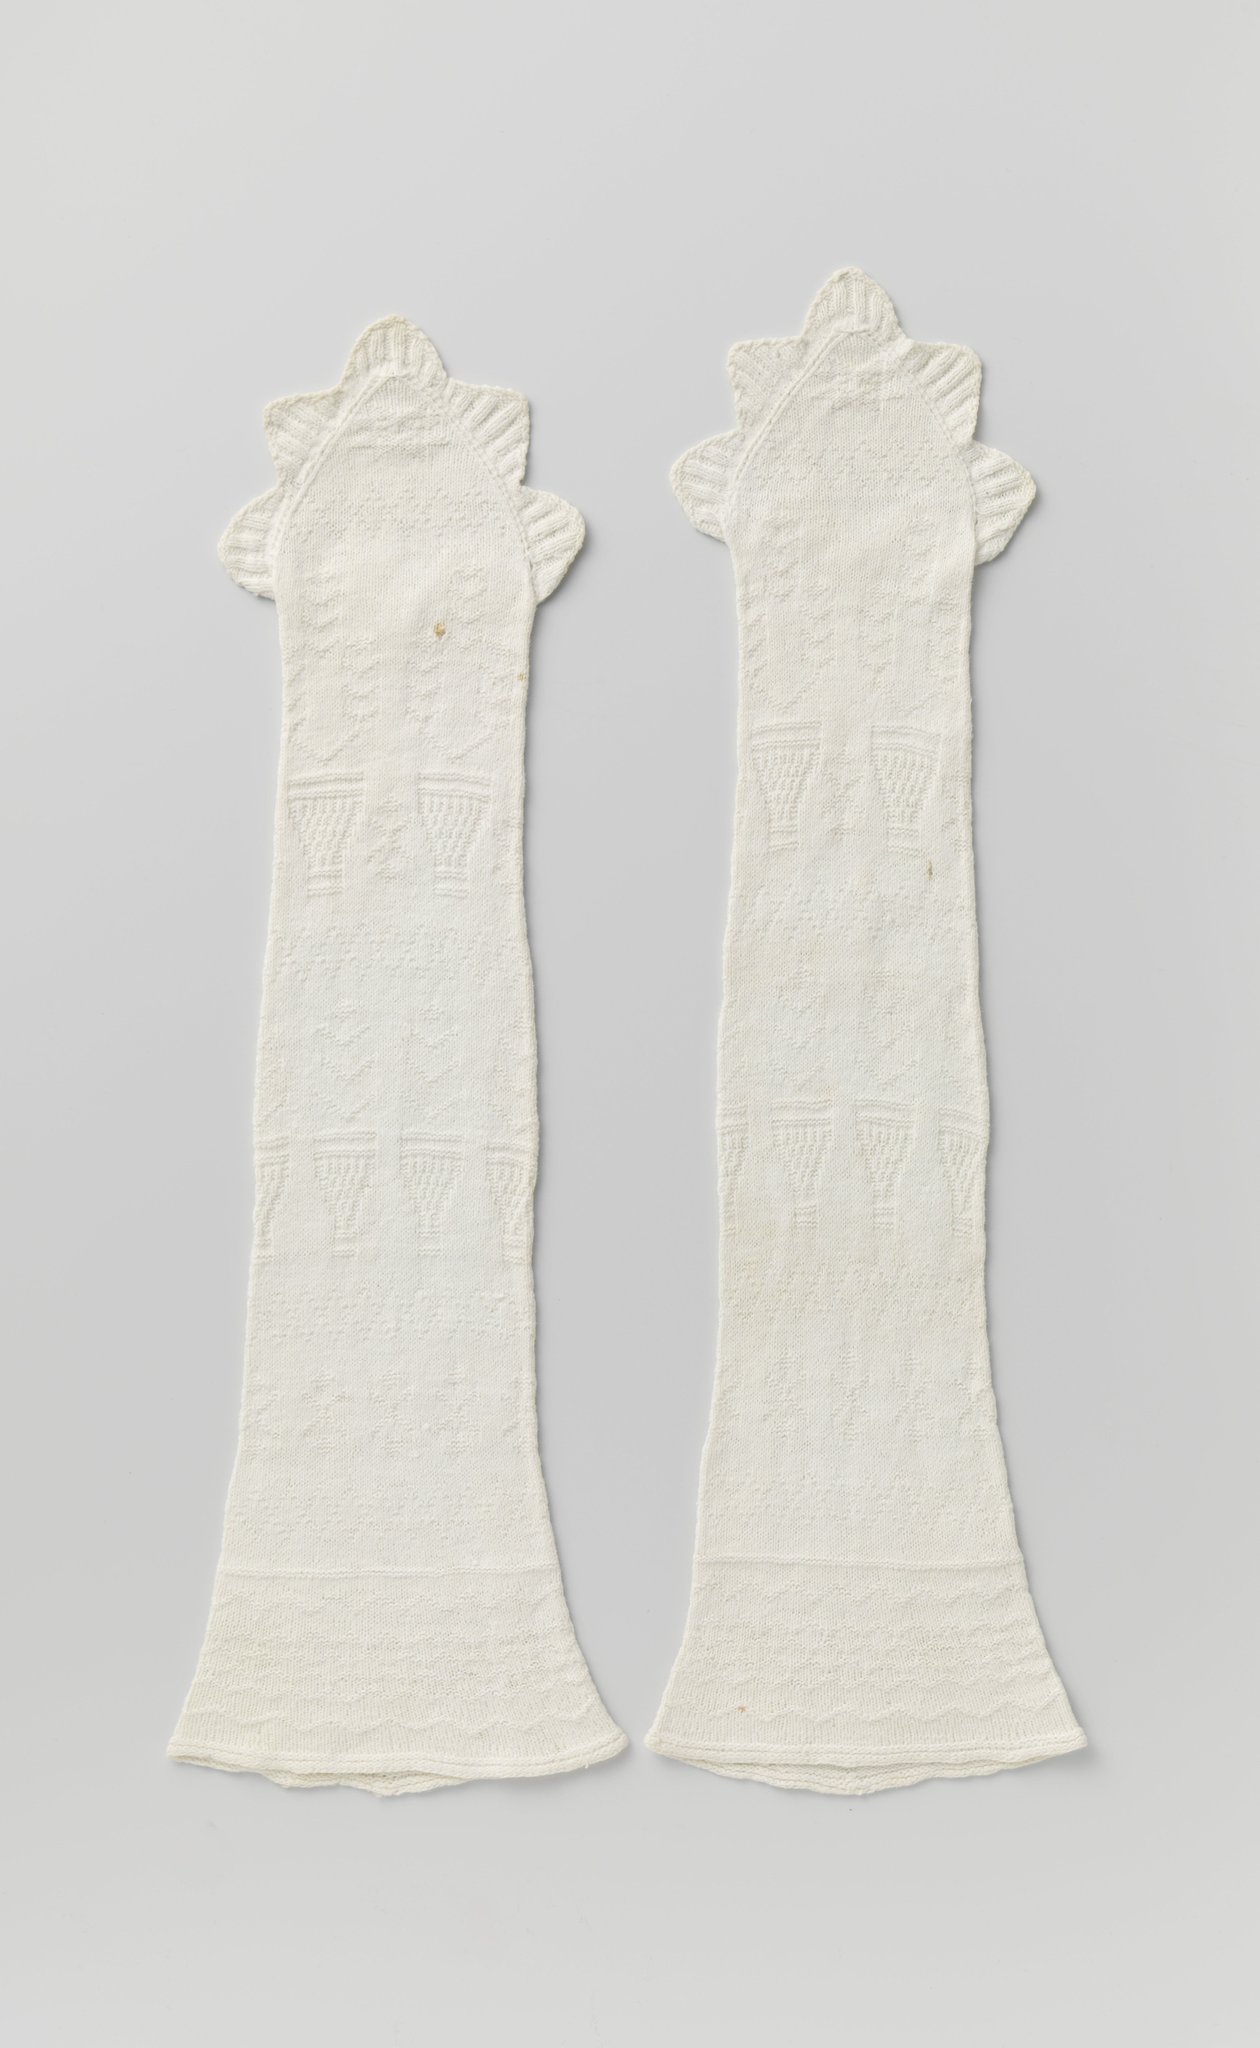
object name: clothing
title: Mitaine van witte gebreide katoen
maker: Anonymous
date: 1750-1820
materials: cotton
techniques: knitting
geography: western europe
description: Mitaine van witte gebreide katoen, met een patroon van dwarsbenen, elk met een ander motief. Bovenaan zeven schulpen rondom.